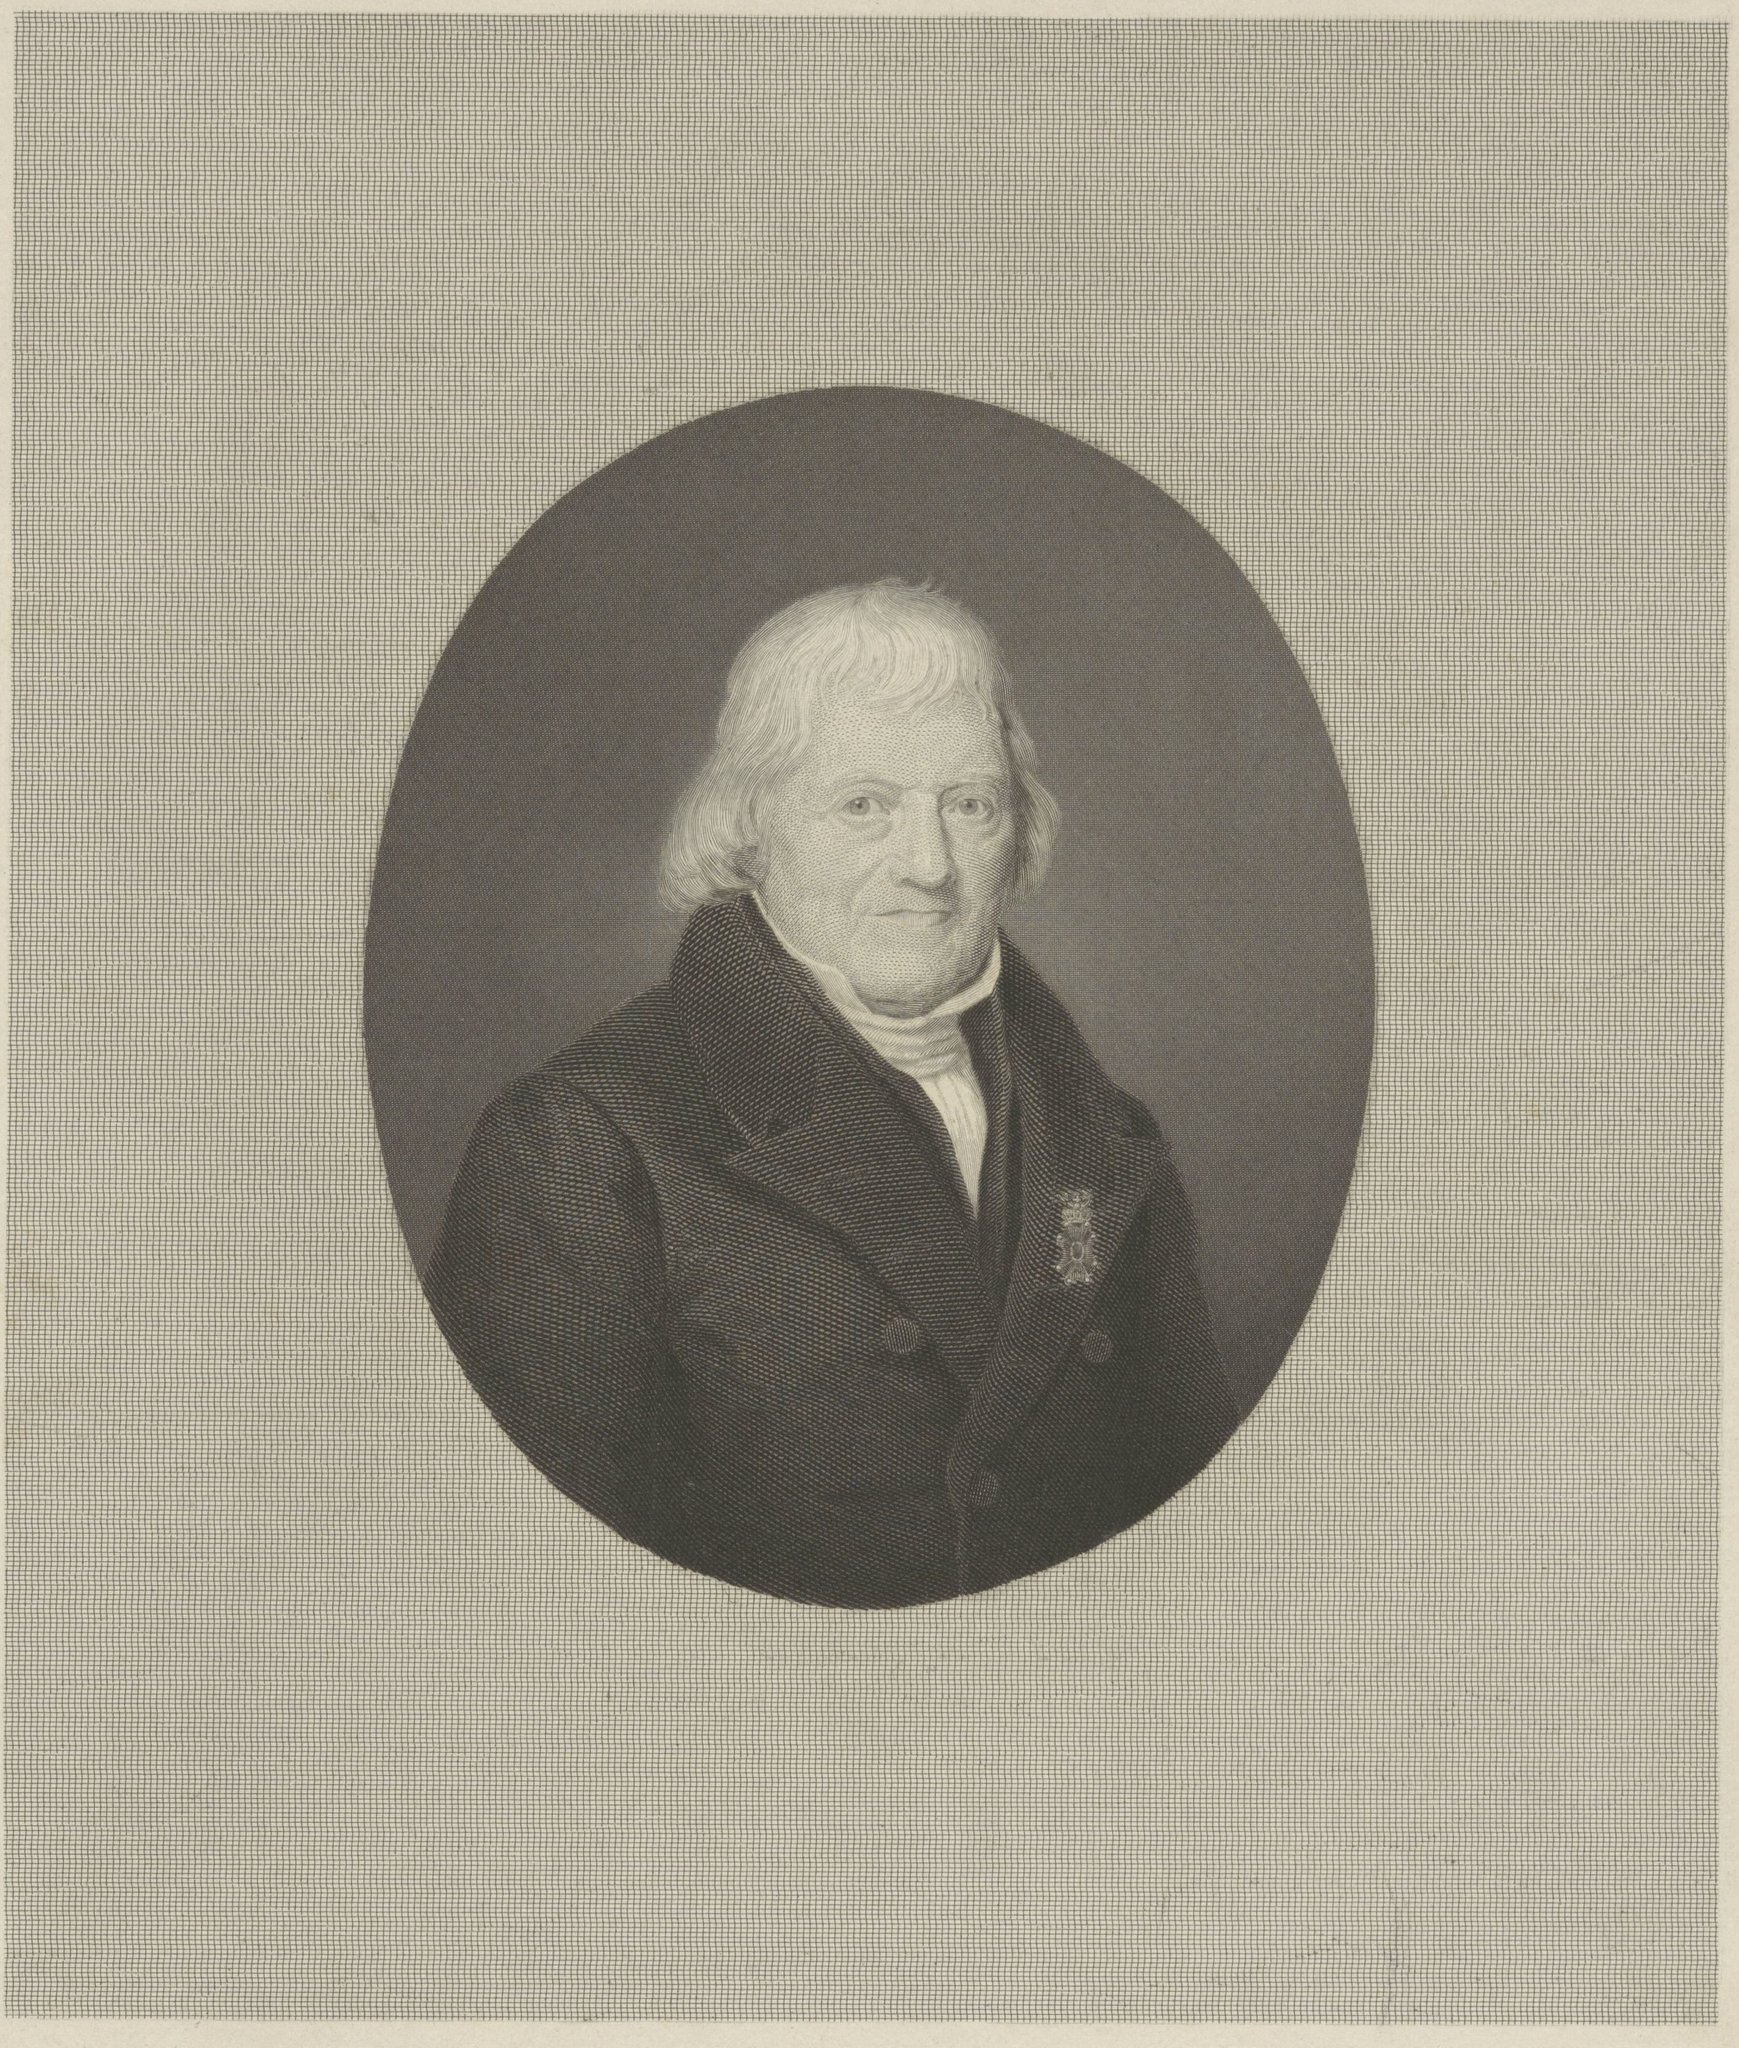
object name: print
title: Portret van Johannes Leonardus Wolterbeek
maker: johannes philippus lange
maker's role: print maker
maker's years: 1810-1849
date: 1848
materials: paper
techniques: engraving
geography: netherlands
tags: functionaries and dignitaries ~ protestant churches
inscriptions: inscription: ‘onafgewerkte proef 3.’, company name: ‘Frans Buffa & Zonen / Amsterdam / Uitgevers’, collector's mark: Lugt 2228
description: Portret van de predikant Johannes Leonardus Wolterbeek op 85-jarige leeftijd, buste in ovaal naar rechts.